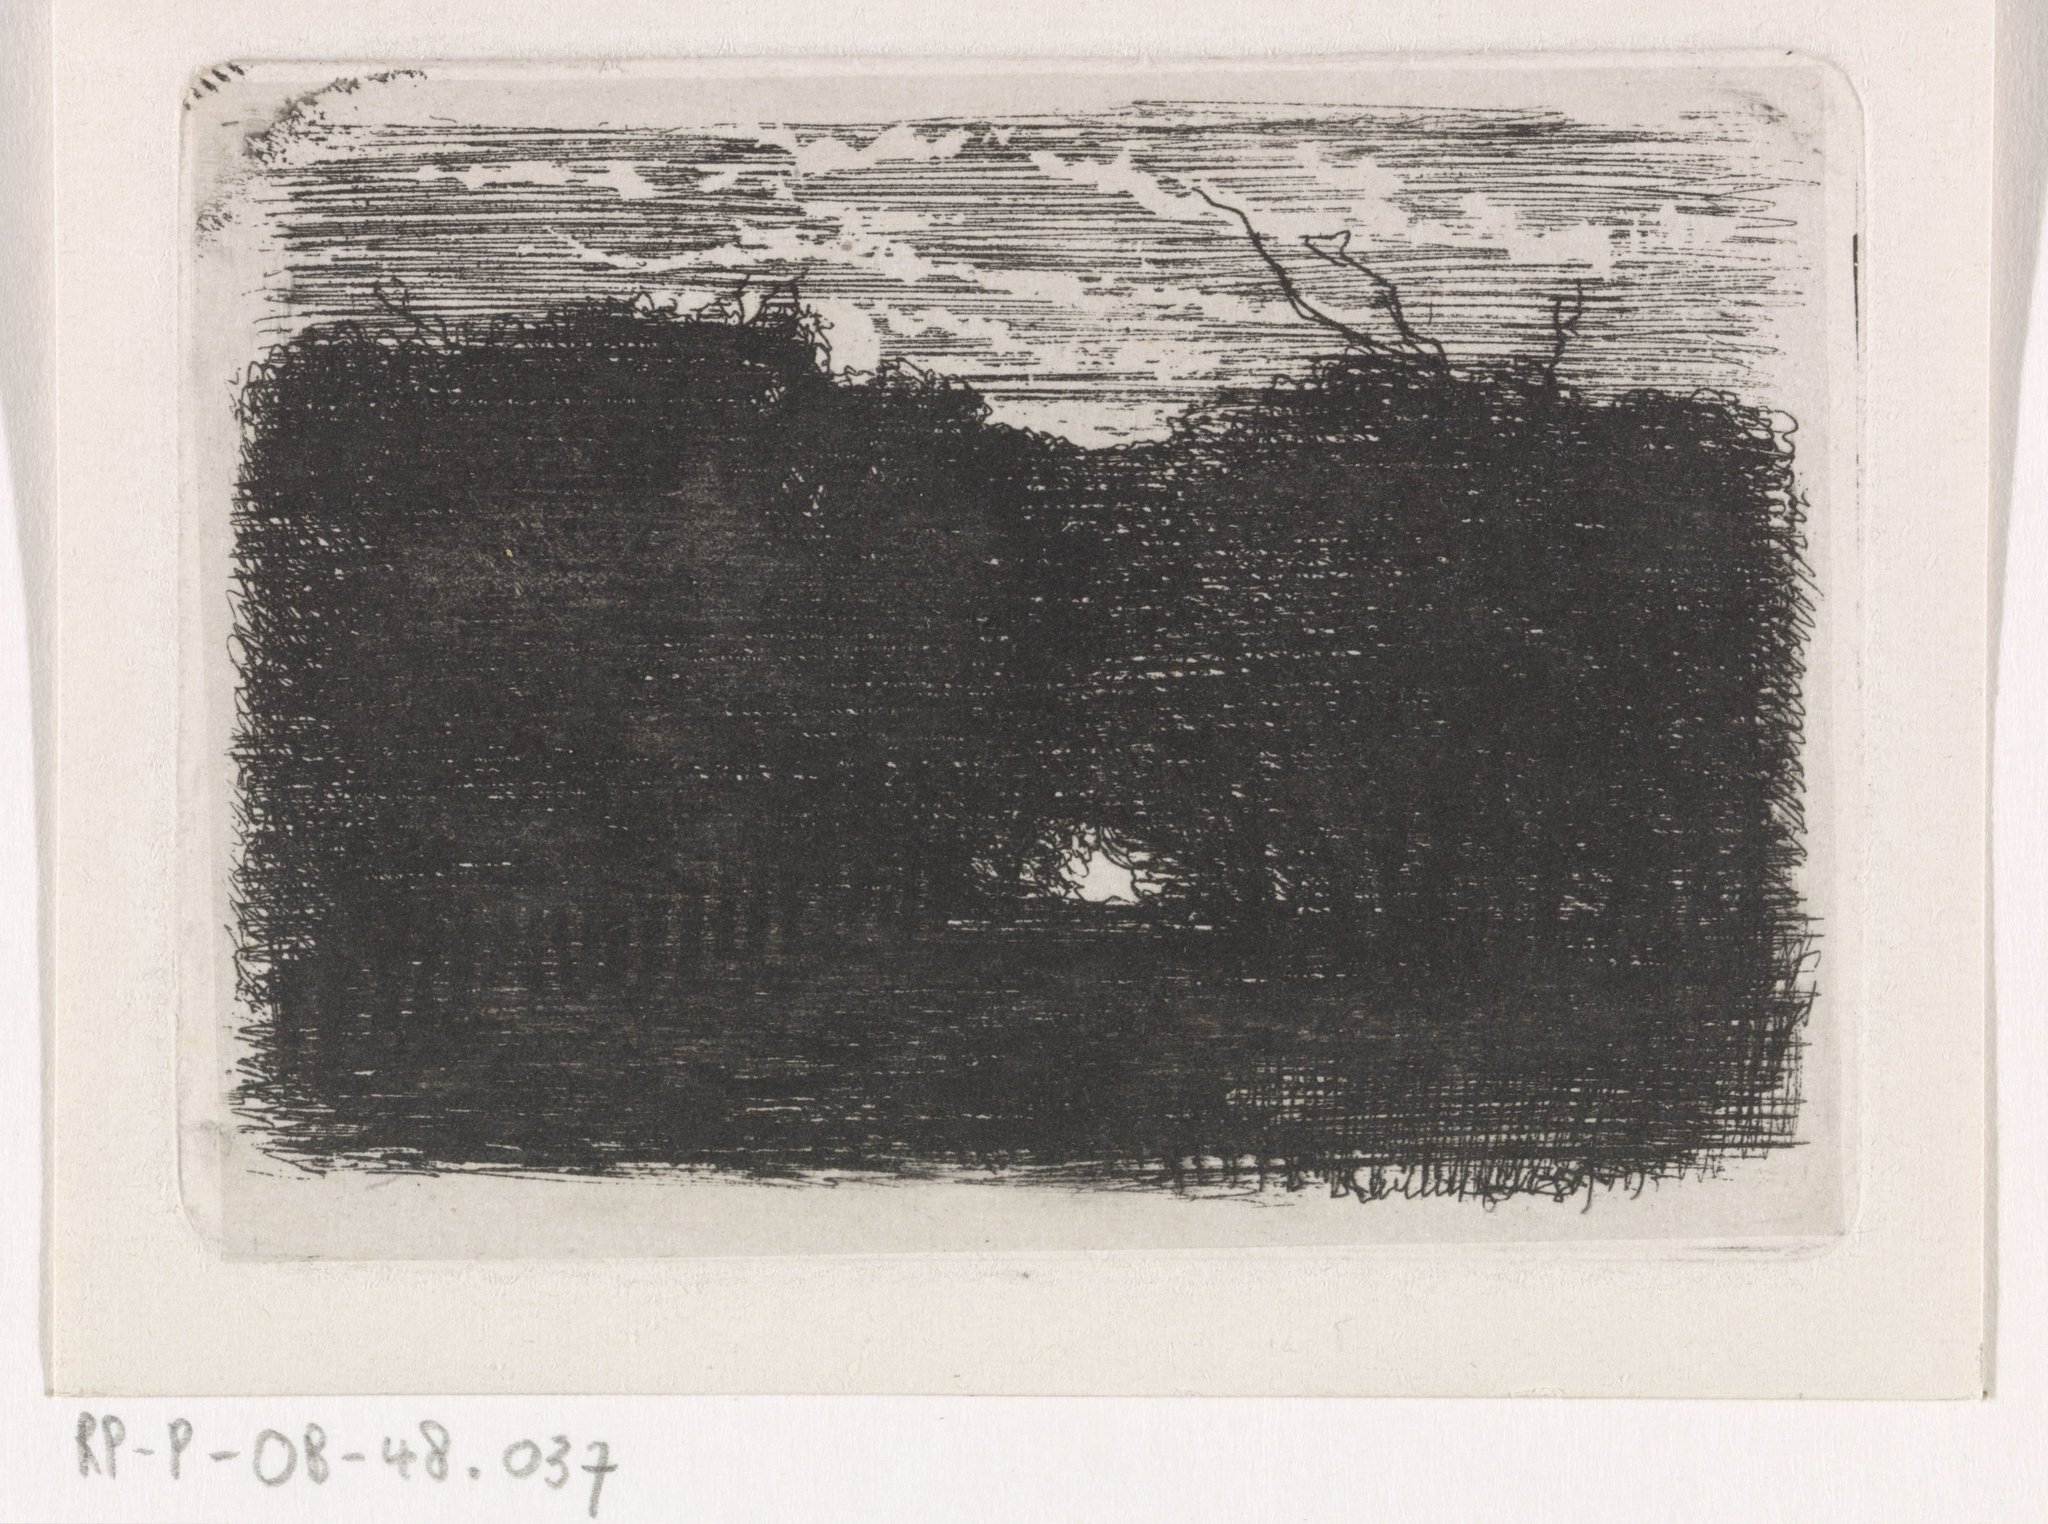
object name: print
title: Bos bij nacht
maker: jacob jan van der maaten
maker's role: draughtsman, print maker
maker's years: 1820-1879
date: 1830-1879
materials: paper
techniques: etching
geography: netherlands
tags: night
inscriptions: collector's mark: Lugt 2228